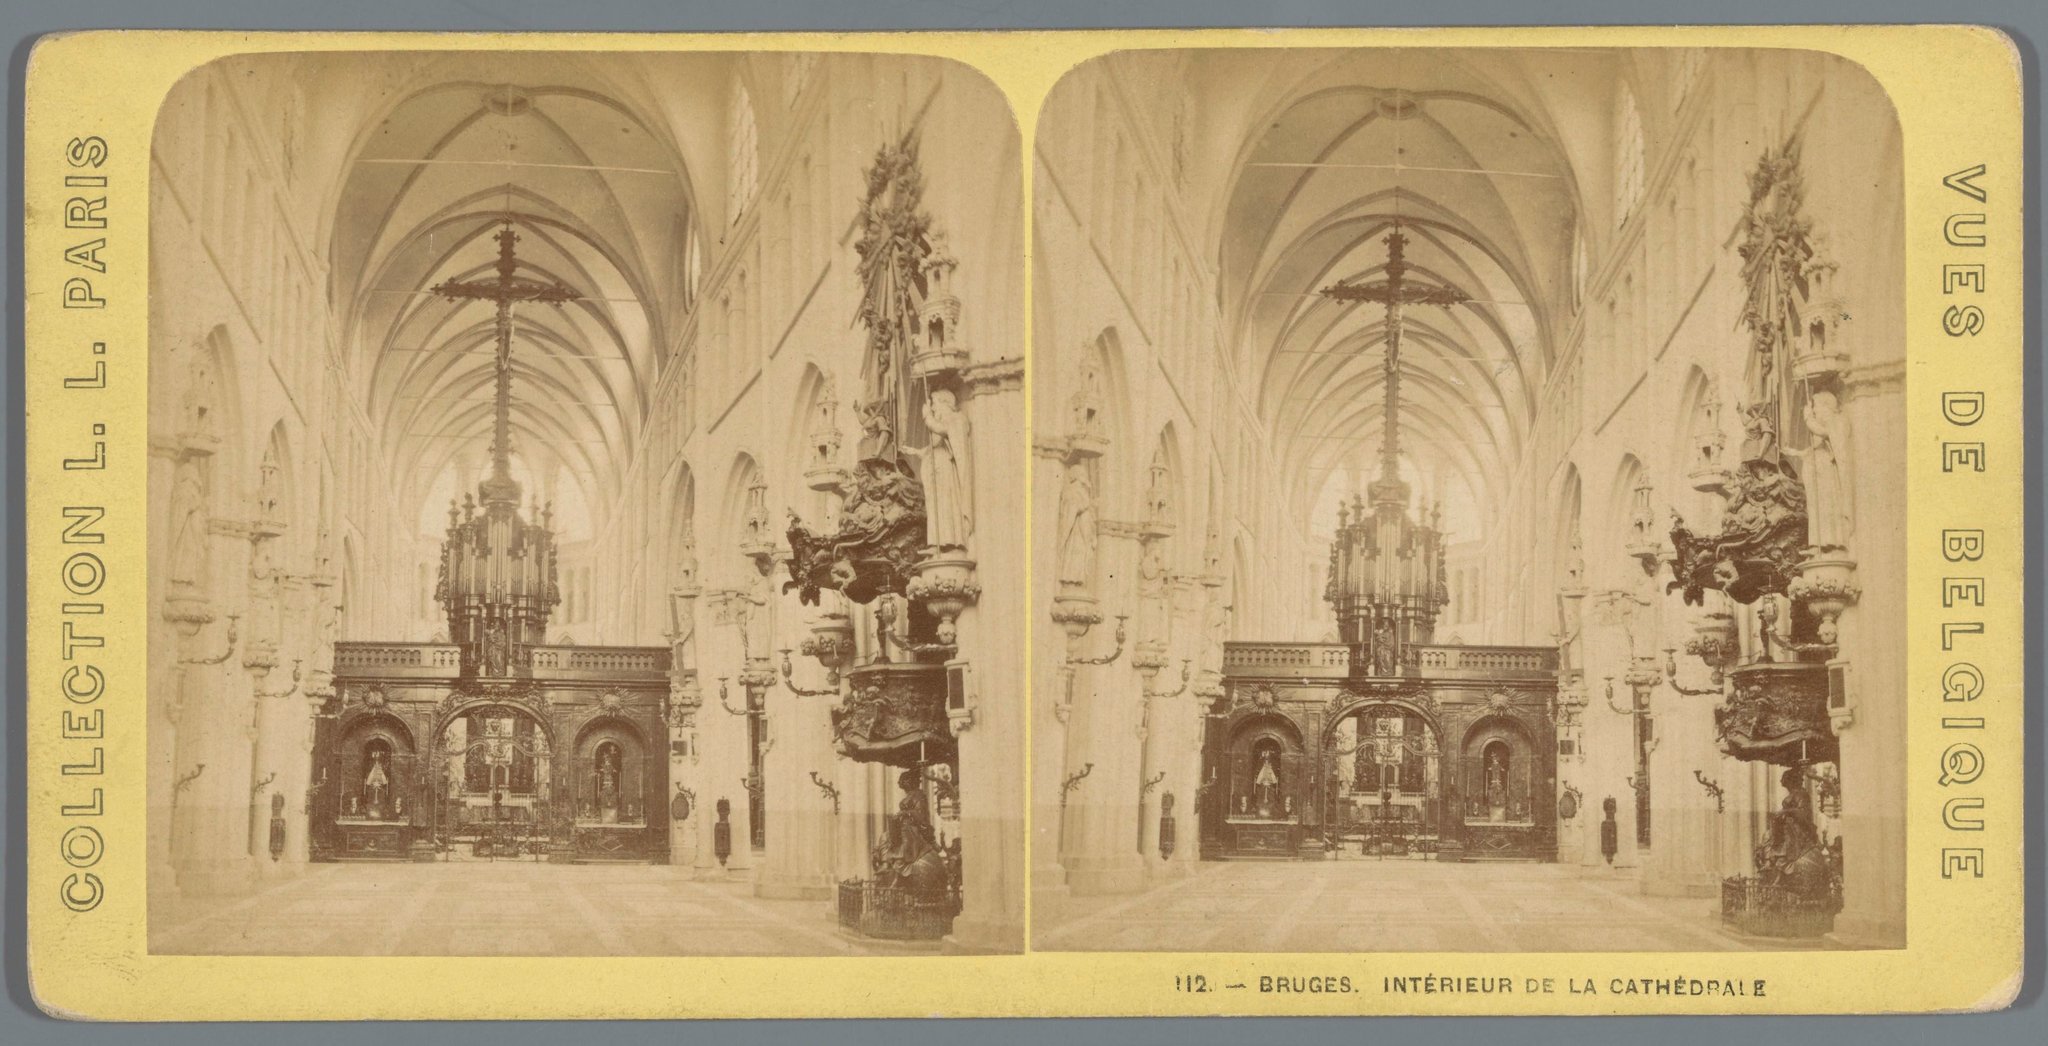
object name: stereograph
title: Interieur van de Onze-Lieve-Vrouwekerk in Brugge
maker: Anonymous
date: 1873-1890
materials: cardboard, paper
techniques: albumen print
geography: bruges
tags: pulpit, ambo, chancel, parts of church interior: choir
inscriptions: number: ‘112.’